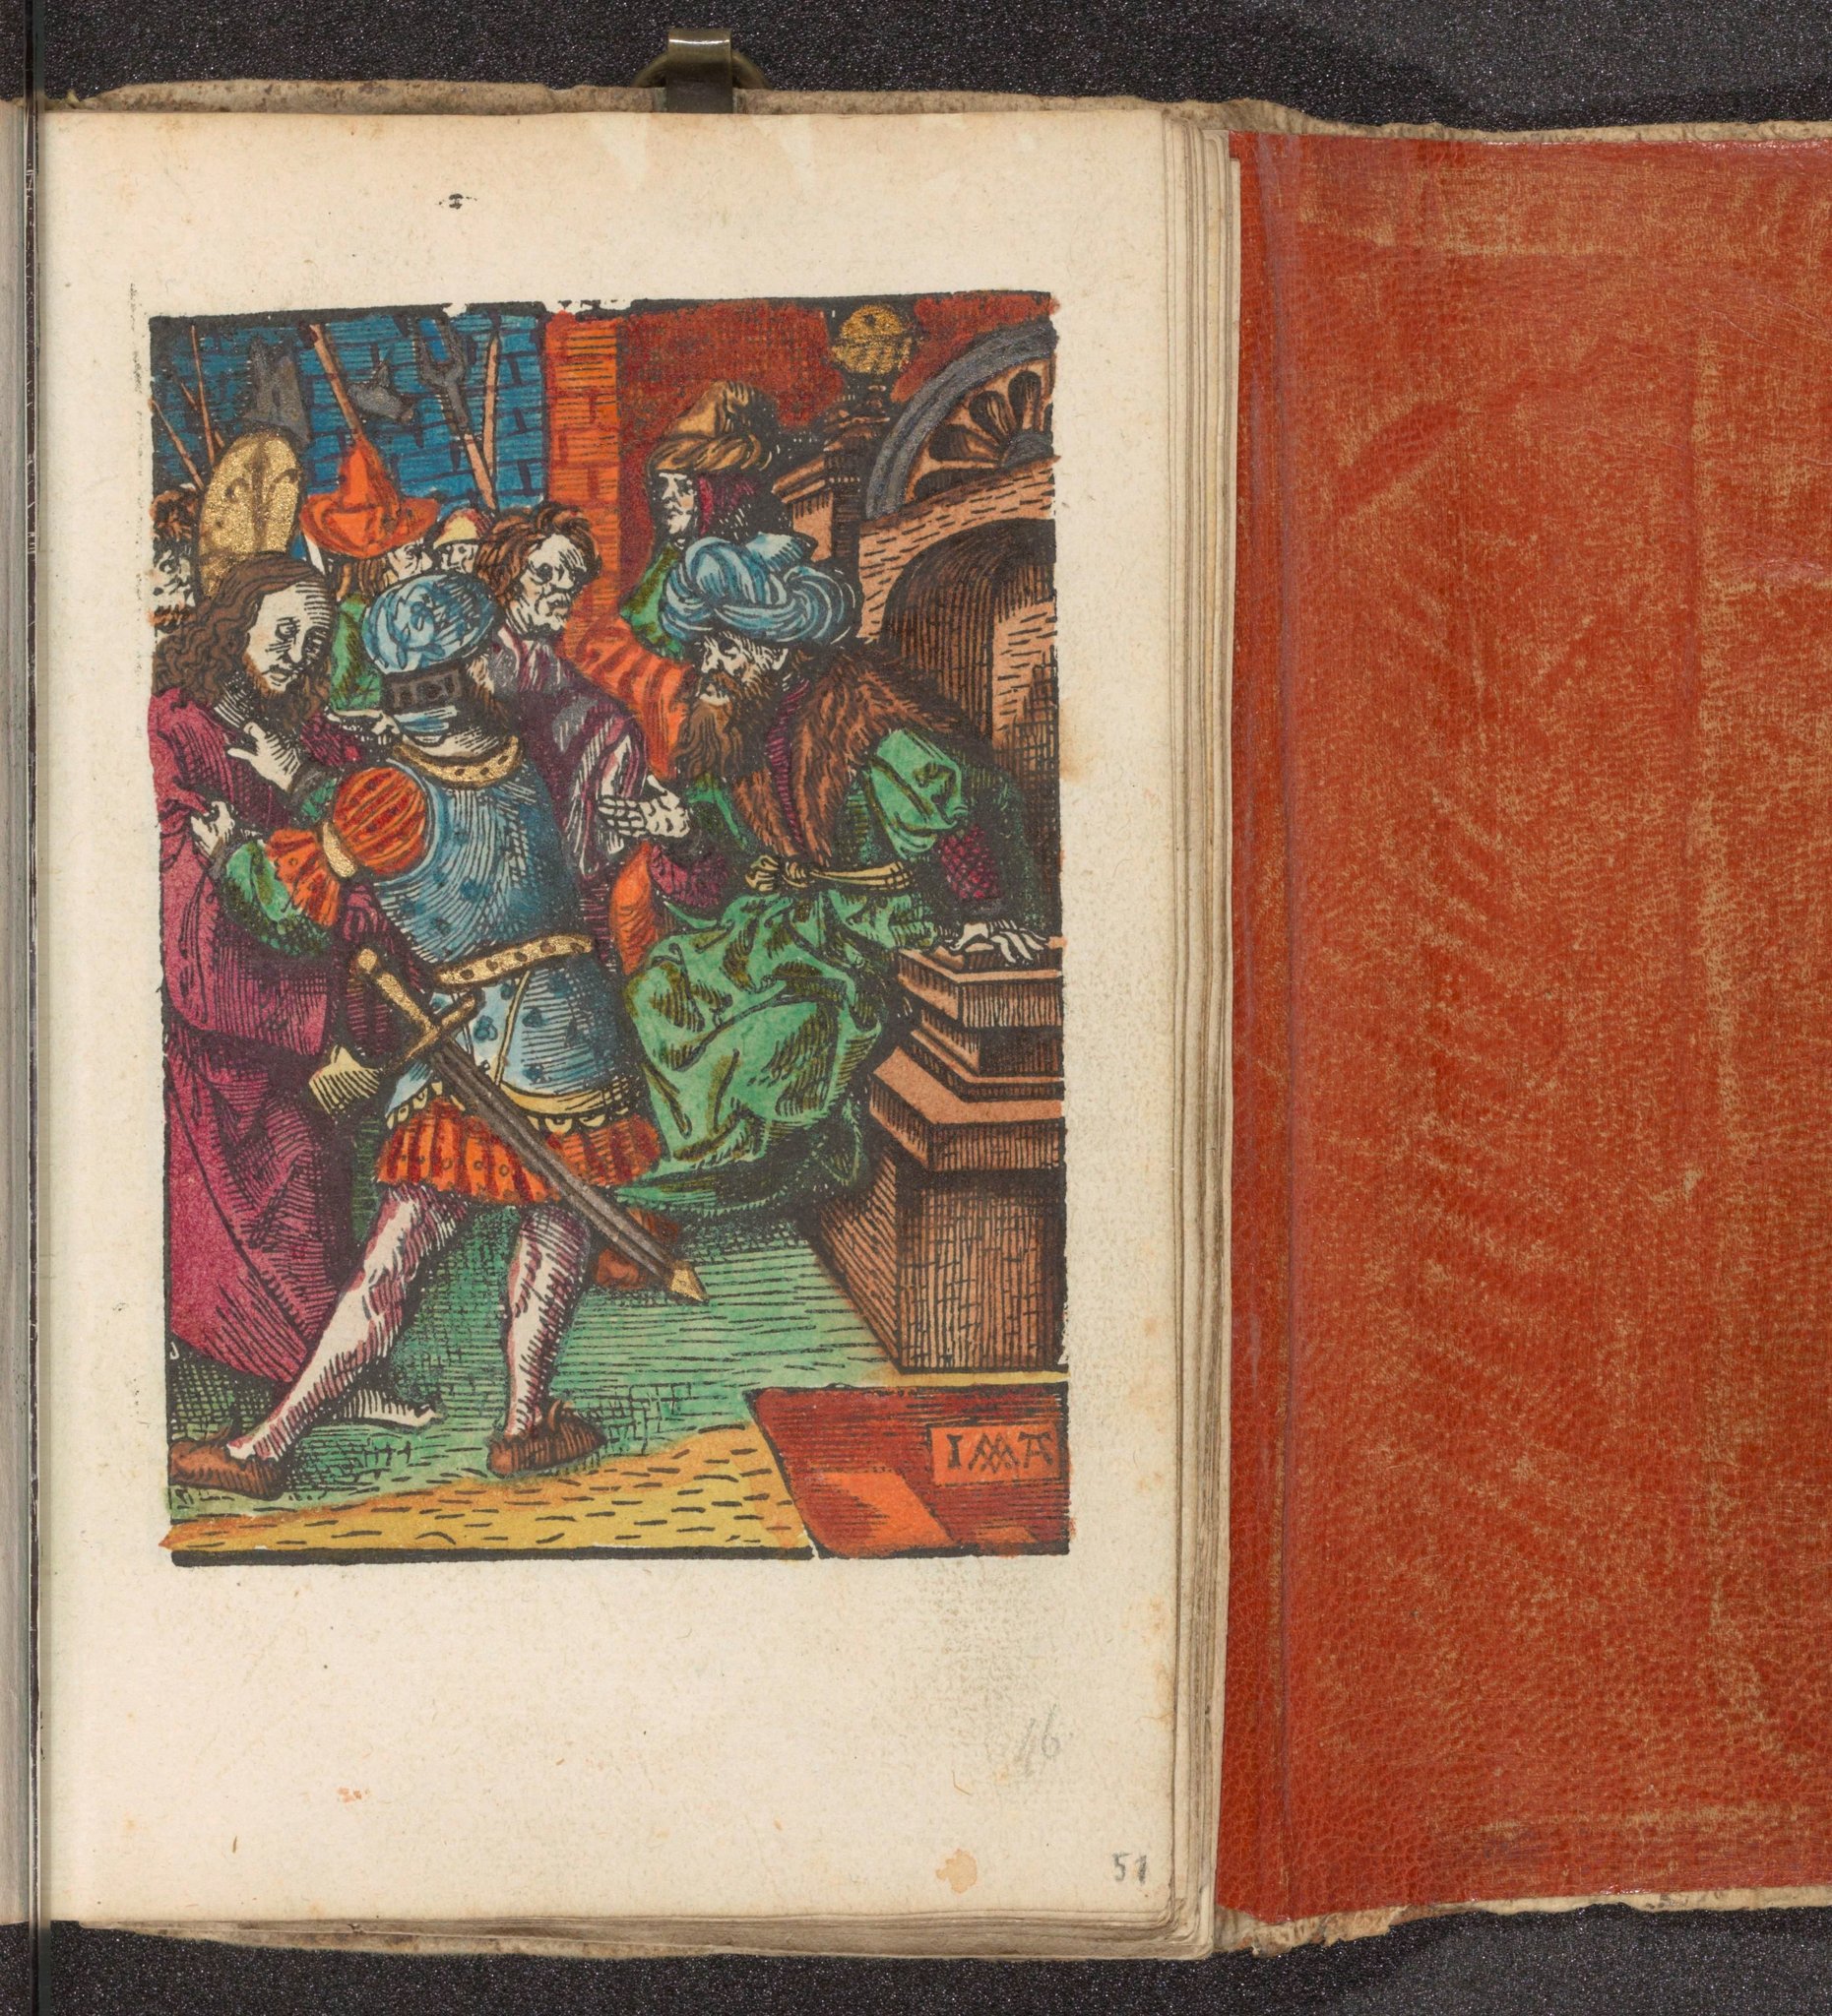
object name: album leaf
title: De kleine Passie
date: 1520-1521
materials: paper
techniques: hand coloring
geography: amsterdam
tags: christ before pontius pilate (matthew 27:11-26; mark 15:2-15; luke 23:2-7, 23:13-25; john 18:28 - 19:16), book in which illustrations are essential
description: Christus wordt voorgeleid aan Pilatus, die een tulband draagt en op zijn troon zit. Een soldaat houdt Christus vast. Prent maakt deel uit van een boek.